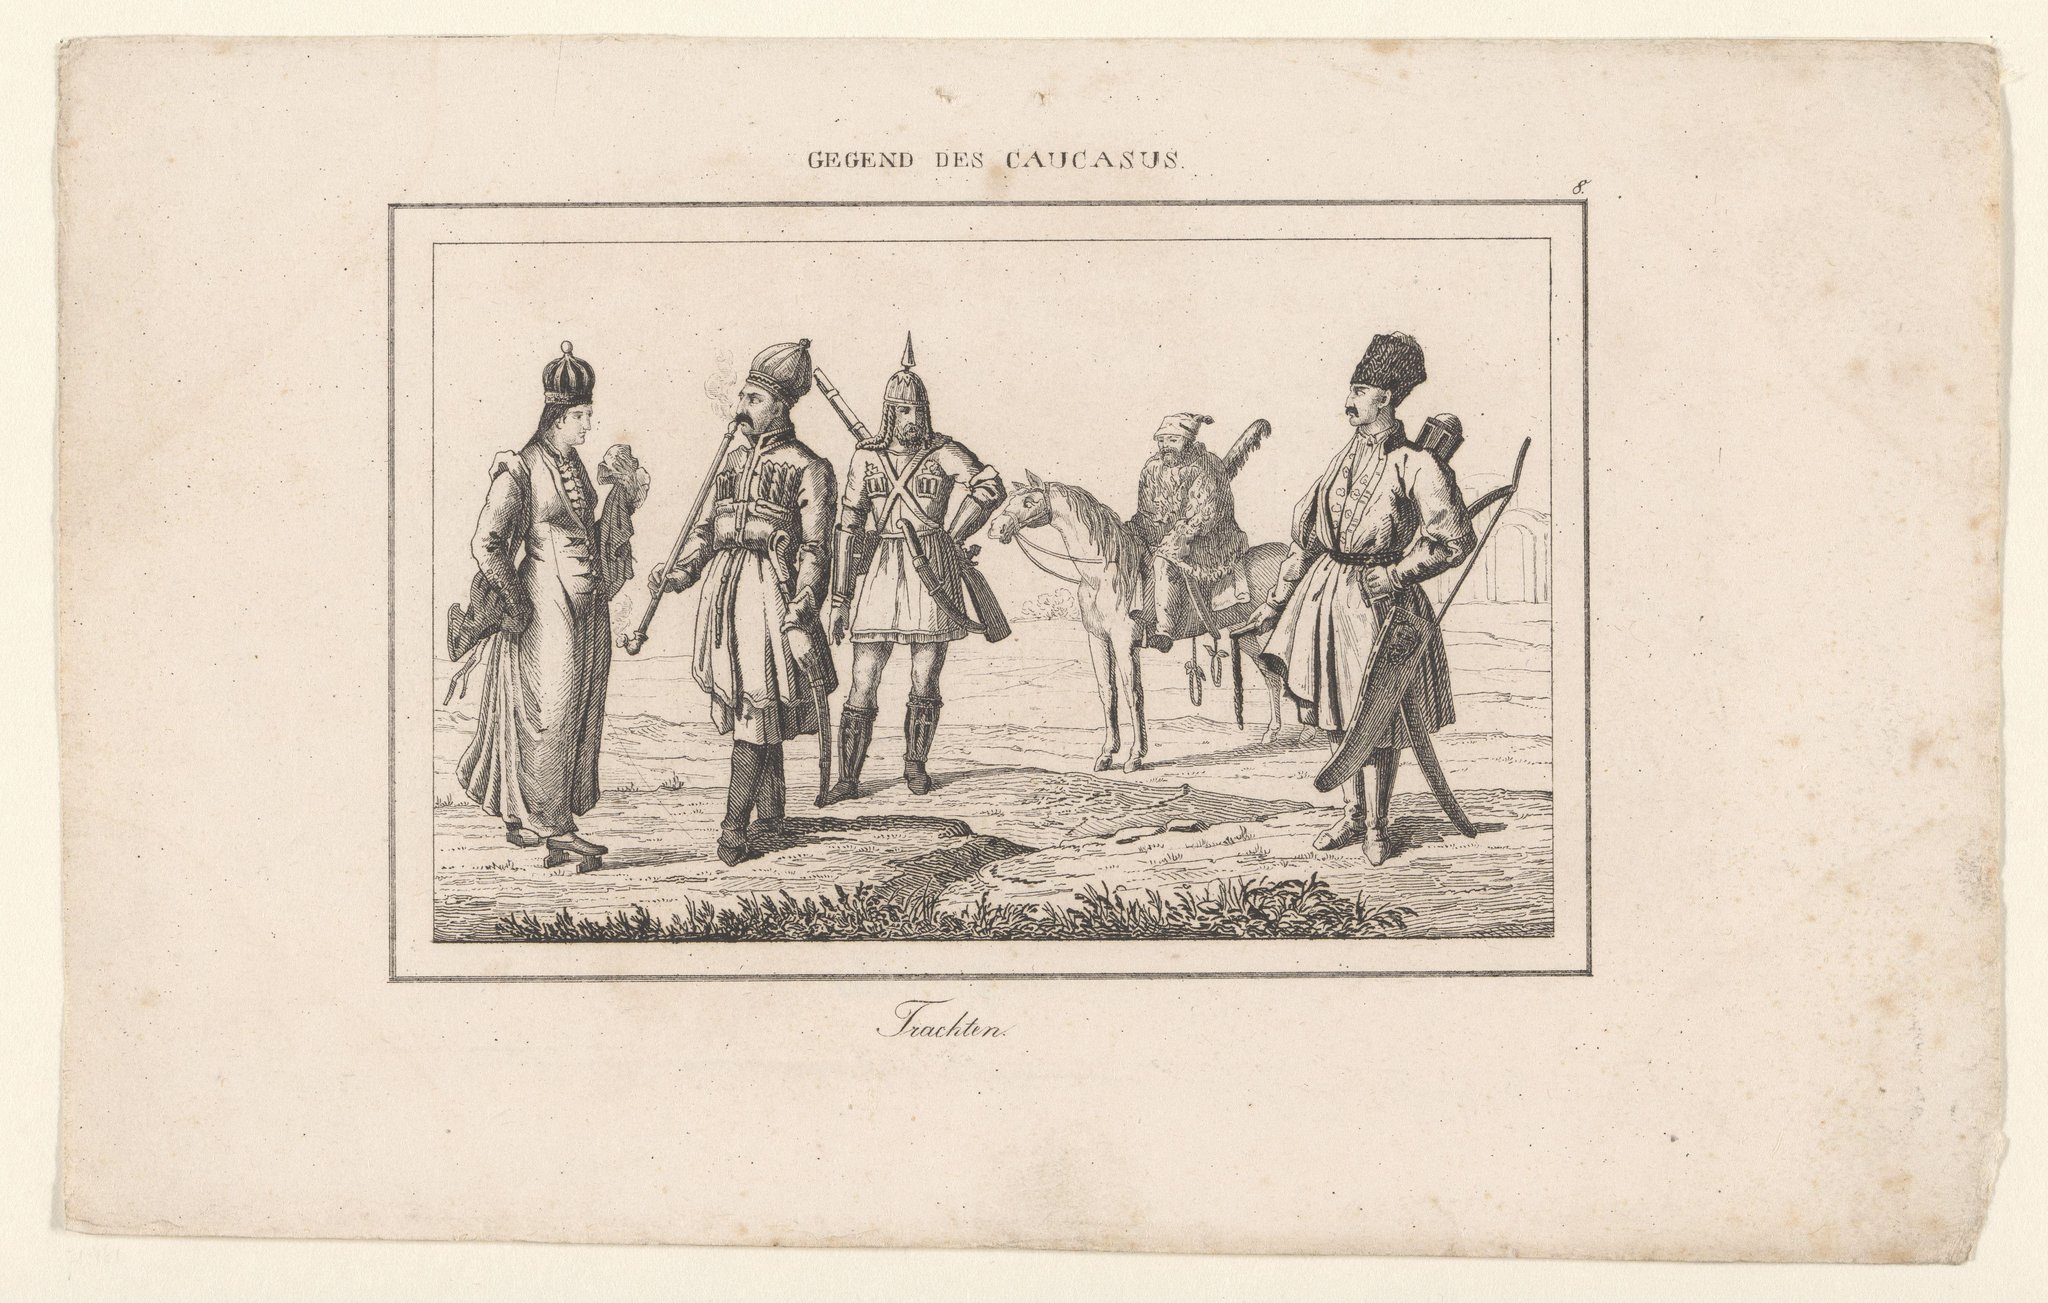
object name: print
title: Figuren uit de Kaukasus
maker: Anonymous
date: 1800-1899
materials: paper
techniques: lithograph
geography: germany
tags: the soldier; the soldier's life, europeans (with name)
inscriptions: collector's mark: Lugt 2228, collector's mark: Lugt 2760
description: Maakt mogelijk deel uit van een serie met figuren uit de Kaukasus.